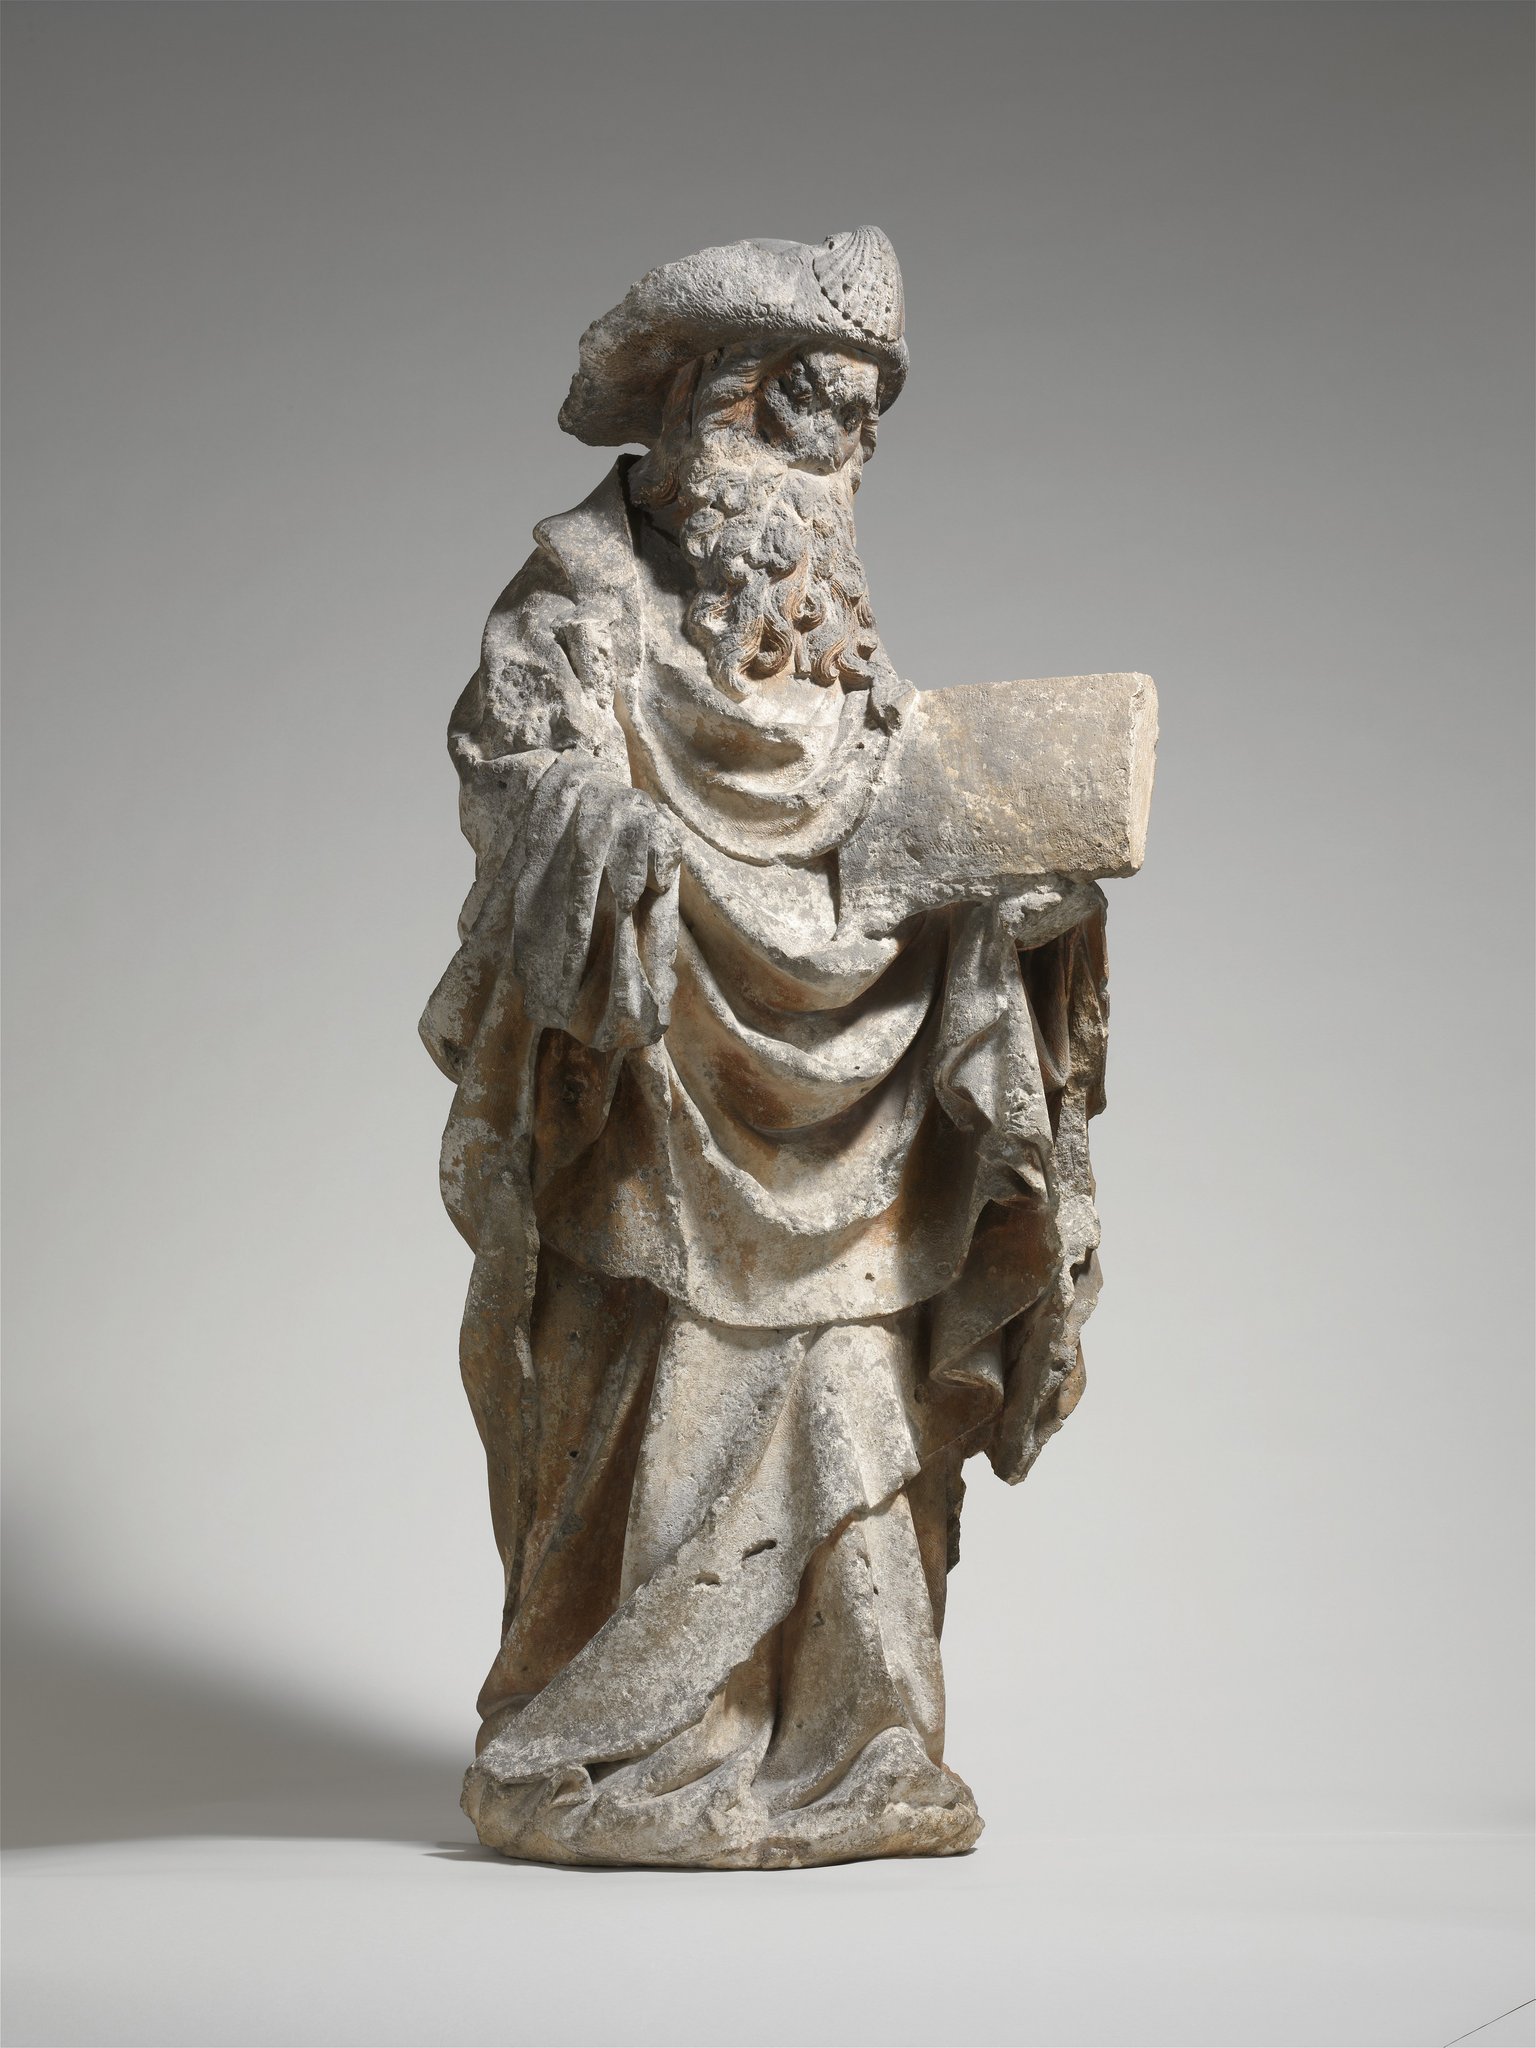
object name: statue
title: Saint James the Greater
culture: french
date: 1450-1475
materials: limestone, paint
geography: france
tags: men,saints